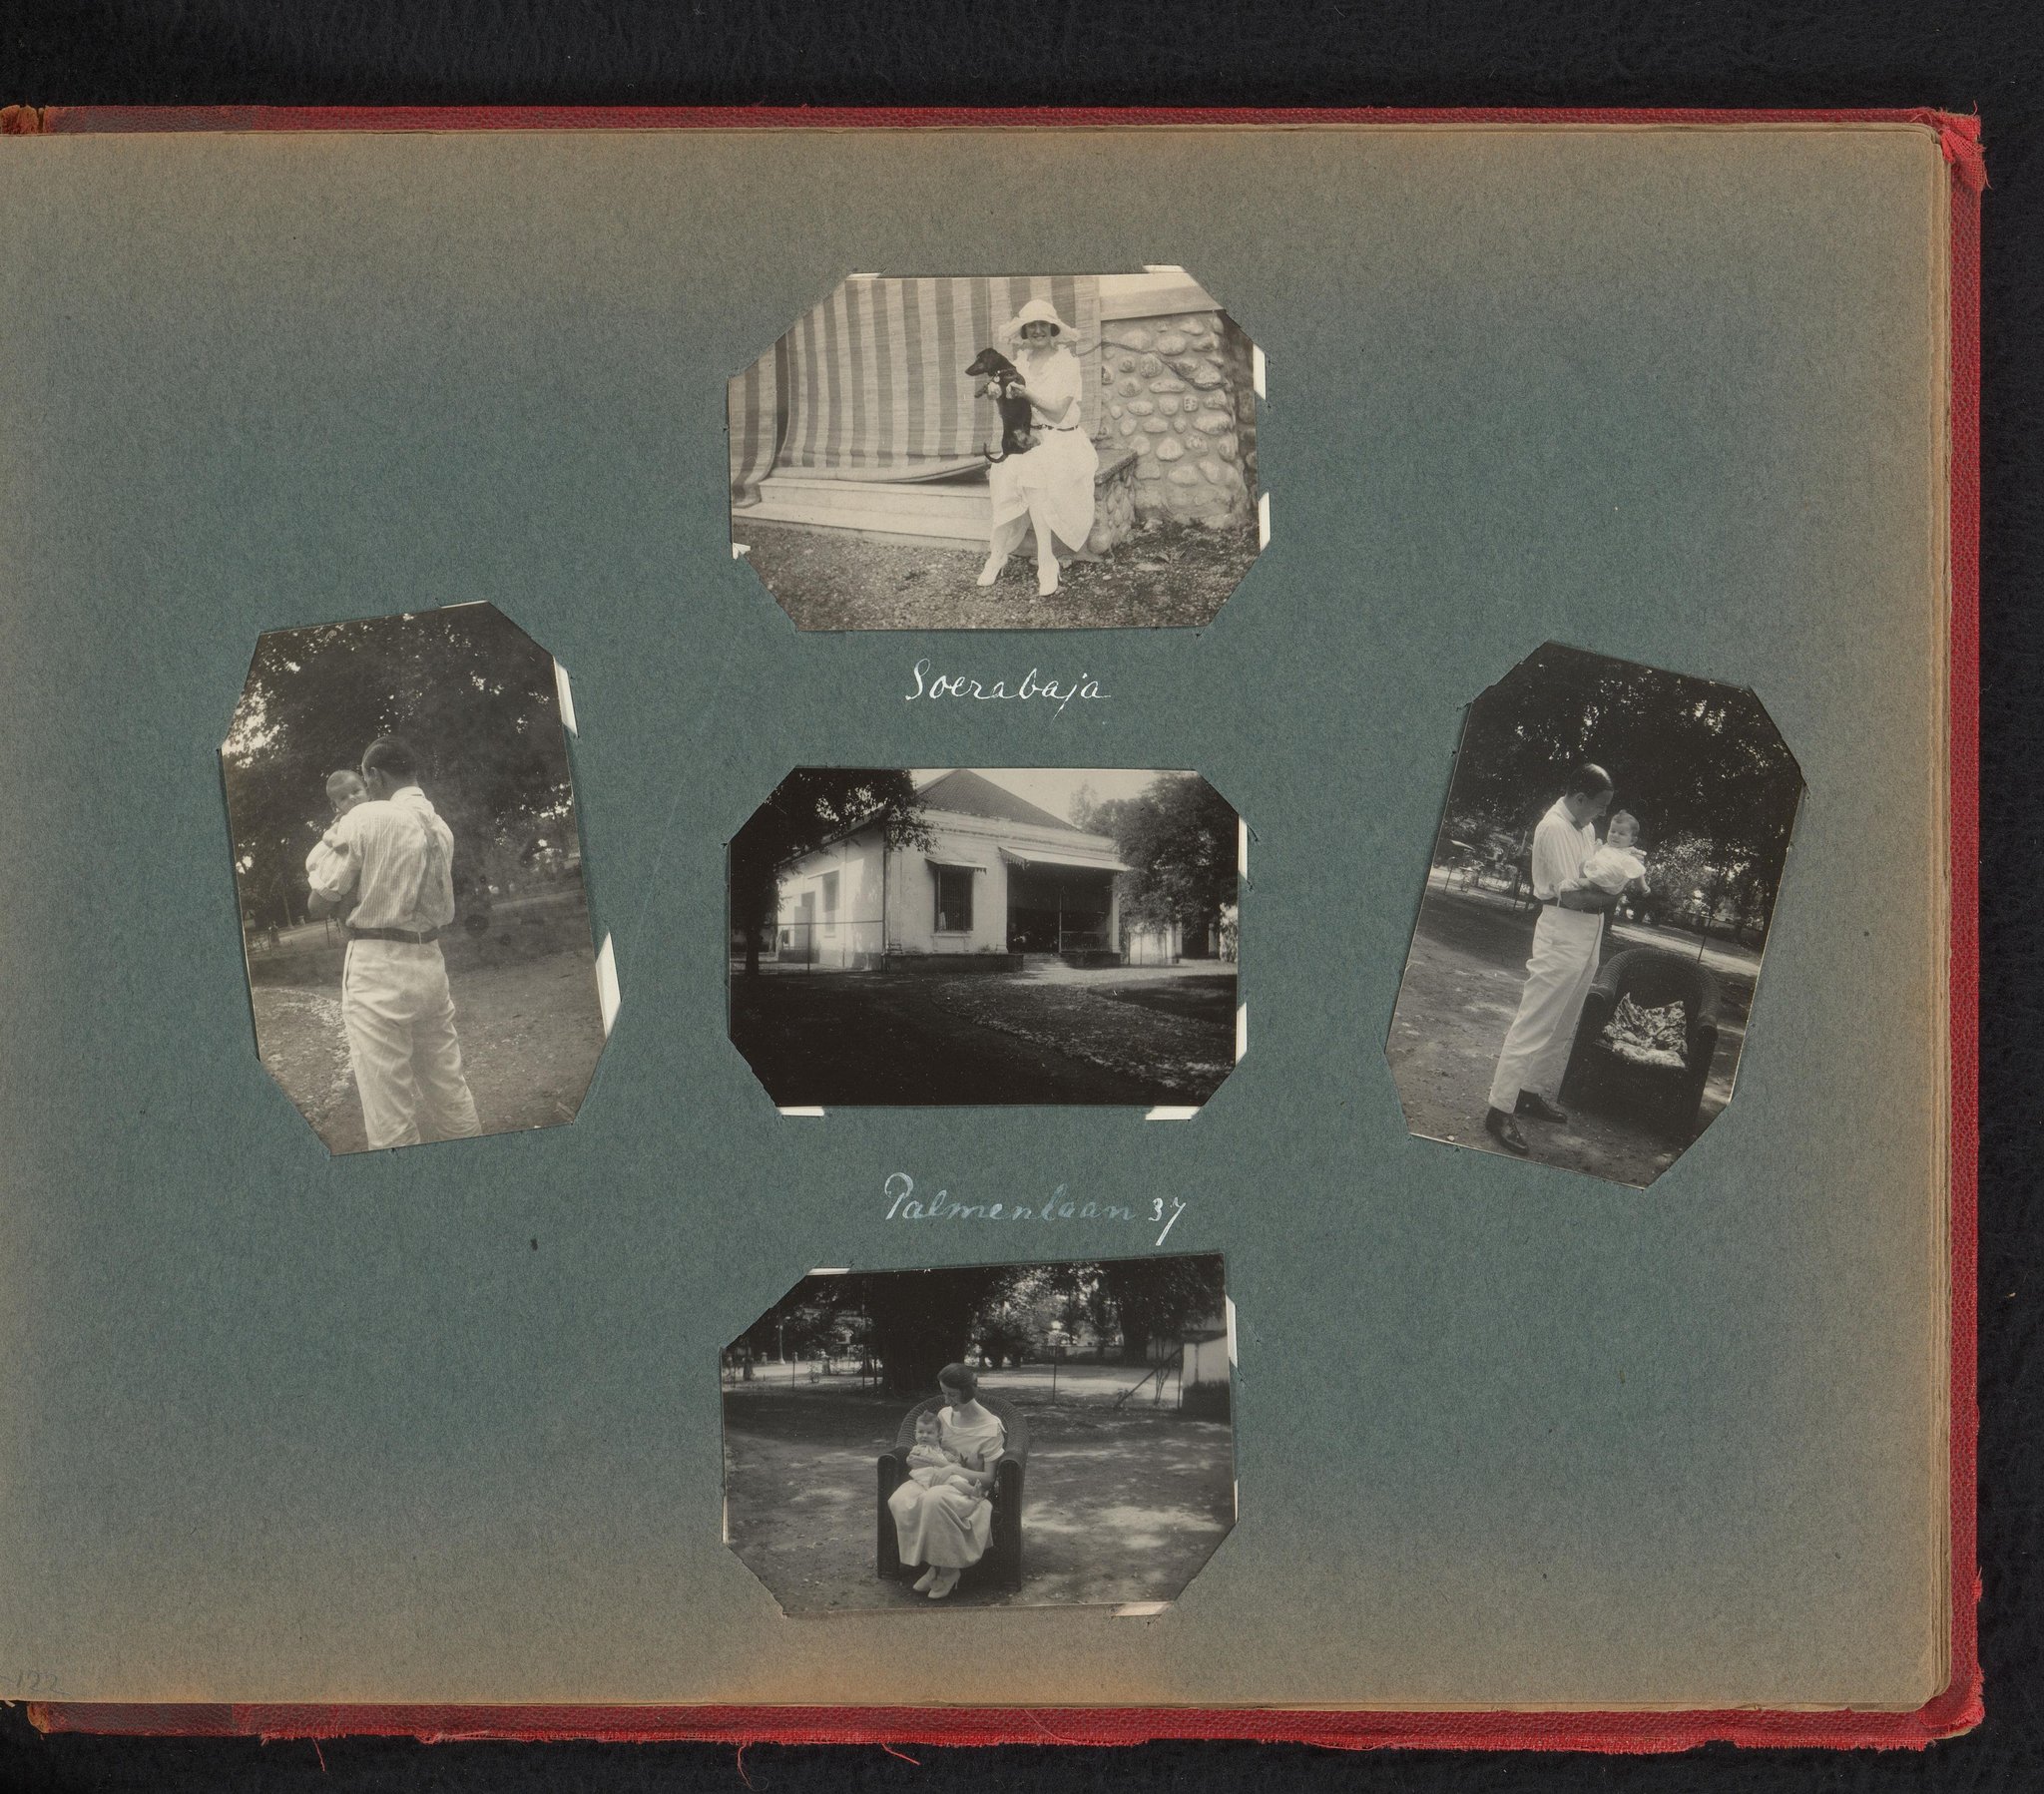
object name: photograph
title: Soerabaja, Palmenlaan 37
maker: charlotte alida boelen-matthes (lot)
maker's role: amateurfotograaf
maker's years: 1889-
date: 1923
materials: paper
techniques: gelatin silver print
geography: surabaya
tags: amsterdam, thailand, parents with their children, surabaya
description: Deze foto's zijn onderdeel van een album.